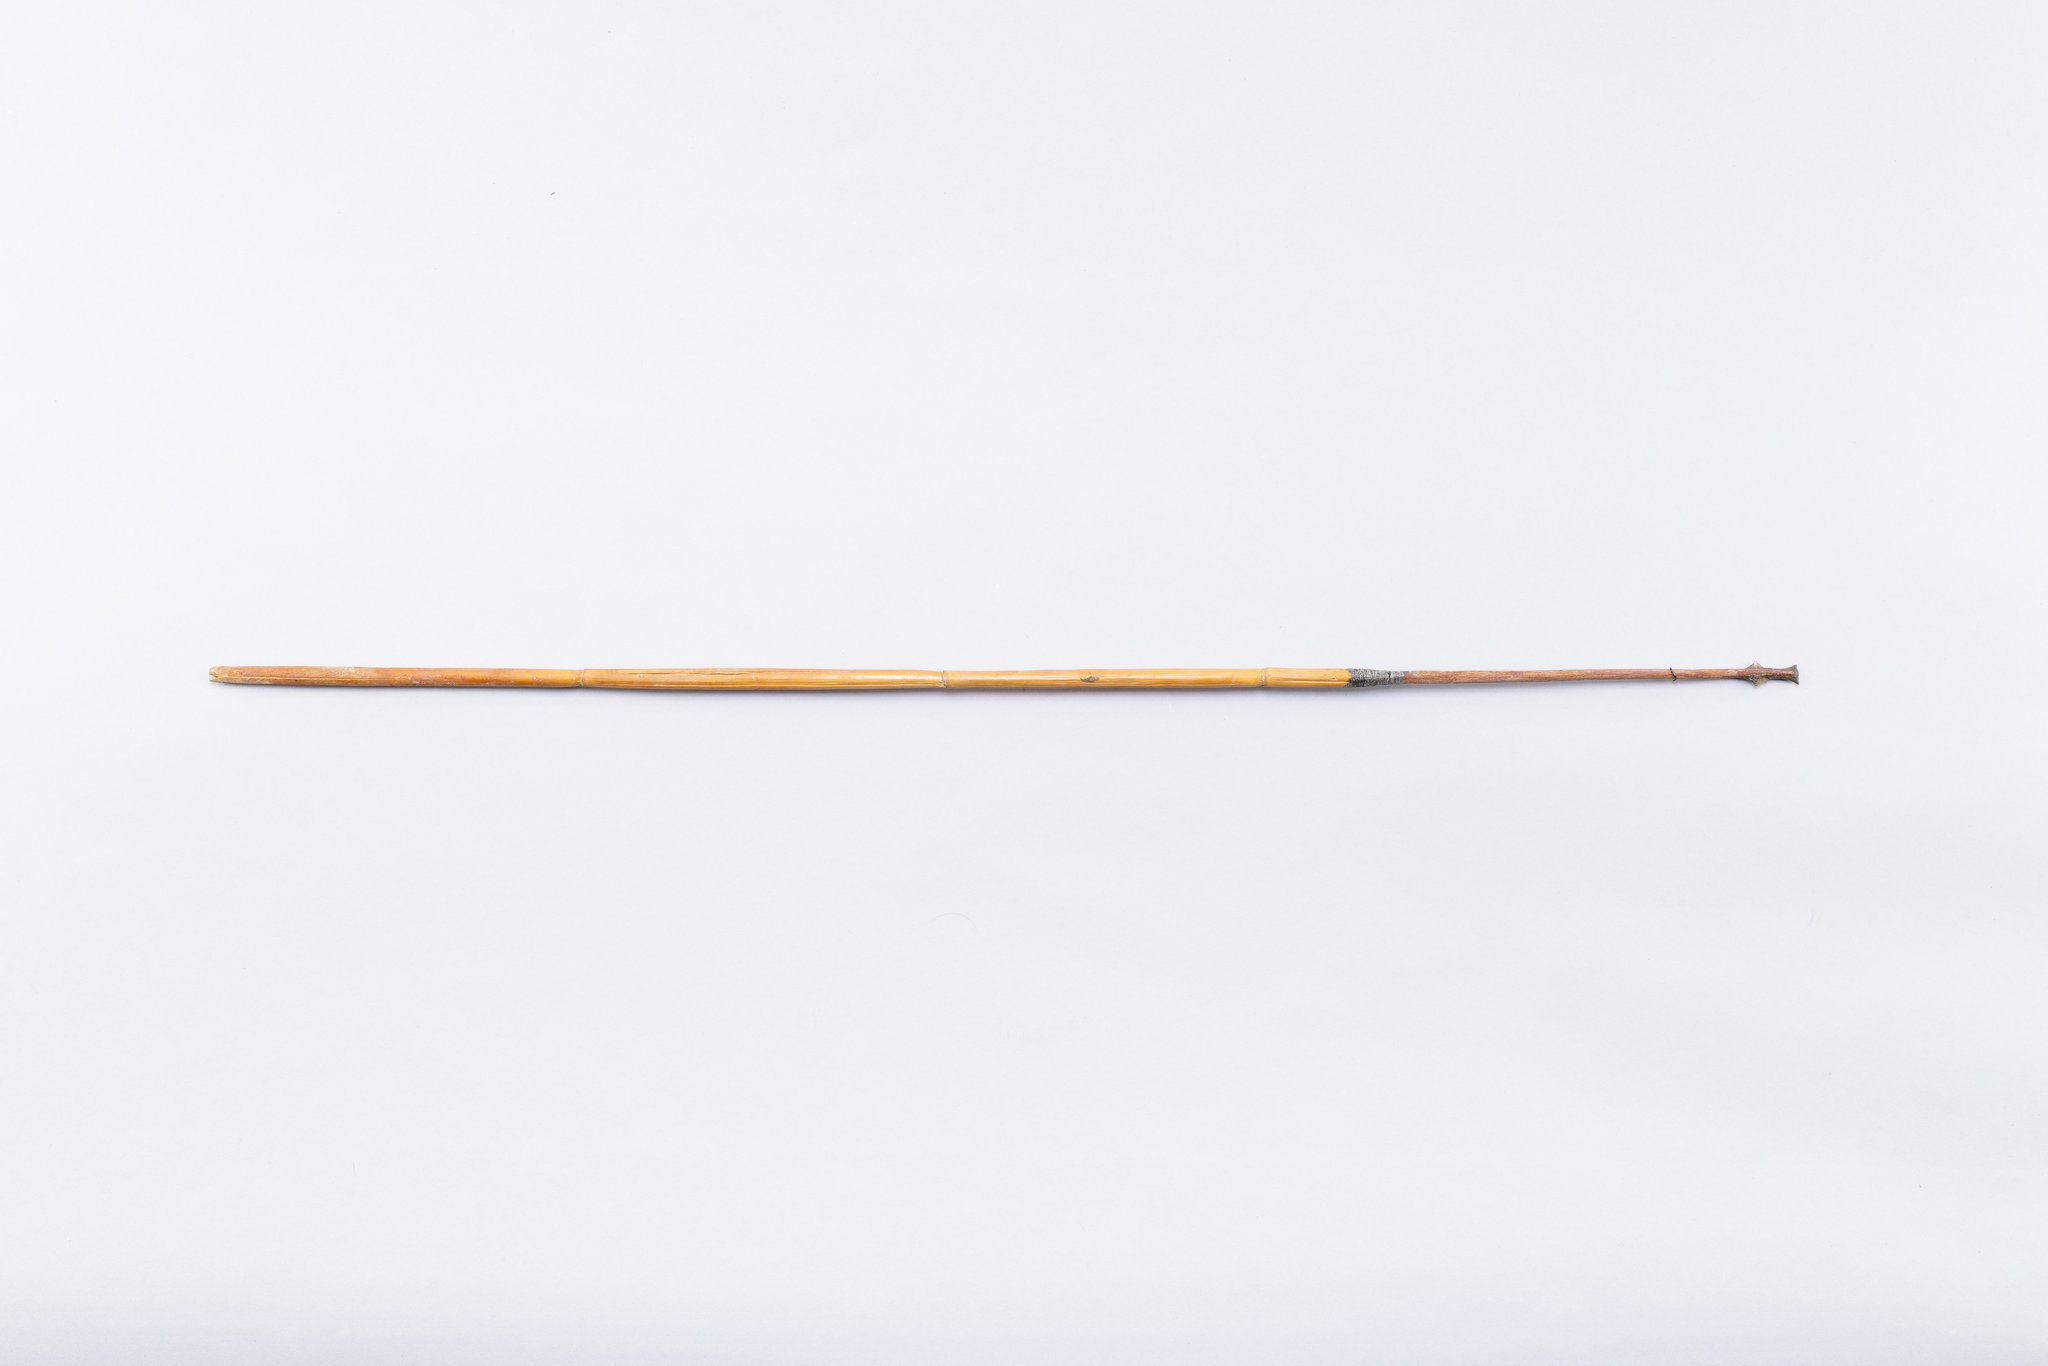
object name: arrow, arrowhead, adhesive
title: Arrow with composite stone tip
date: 1479-1458 BCE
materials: quartz, wood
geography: egypt